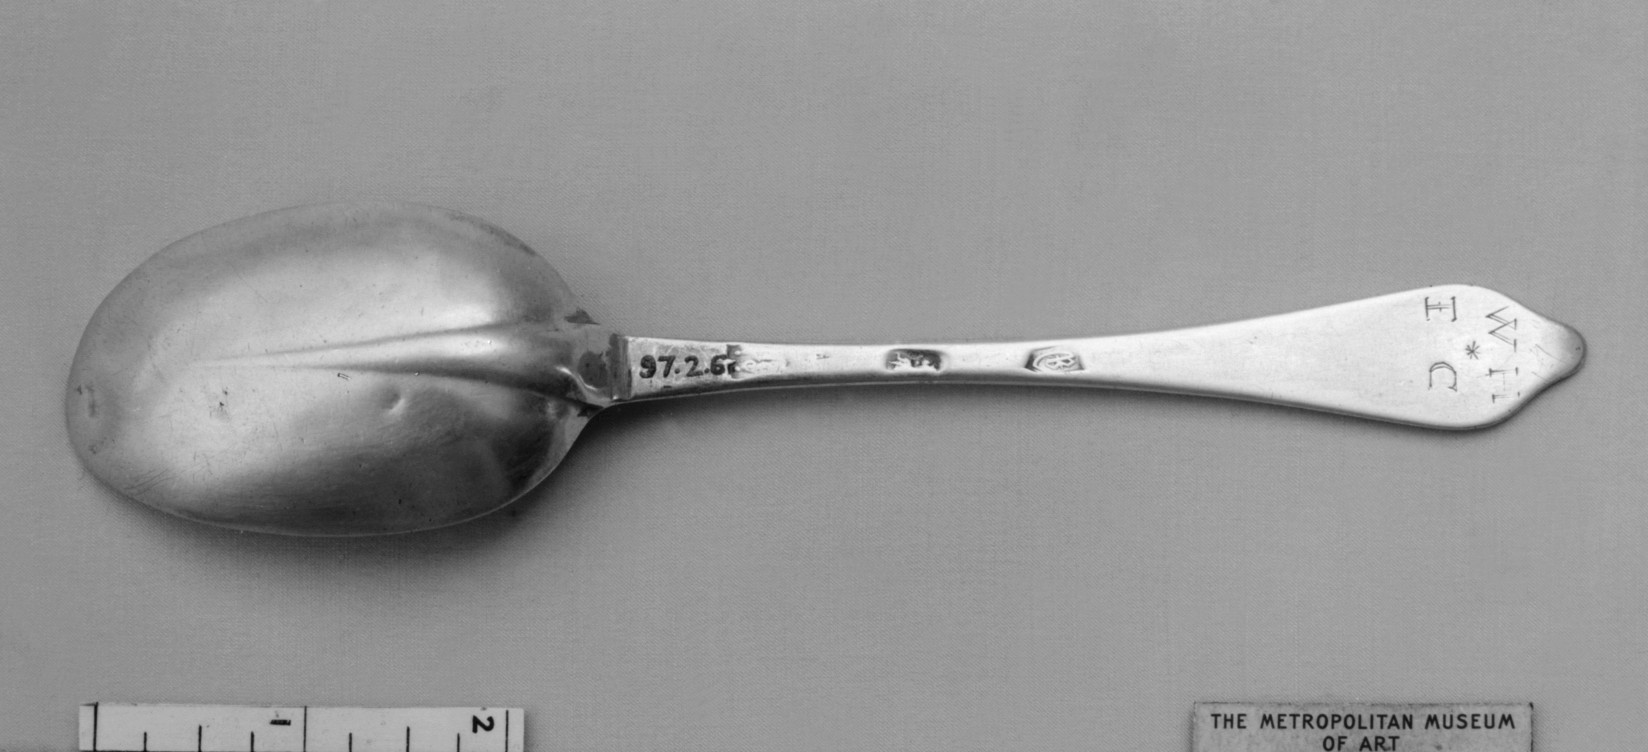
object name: spoon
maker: thomas spackman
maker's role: maker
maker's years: 1700-1713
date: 1712-1713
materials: silver